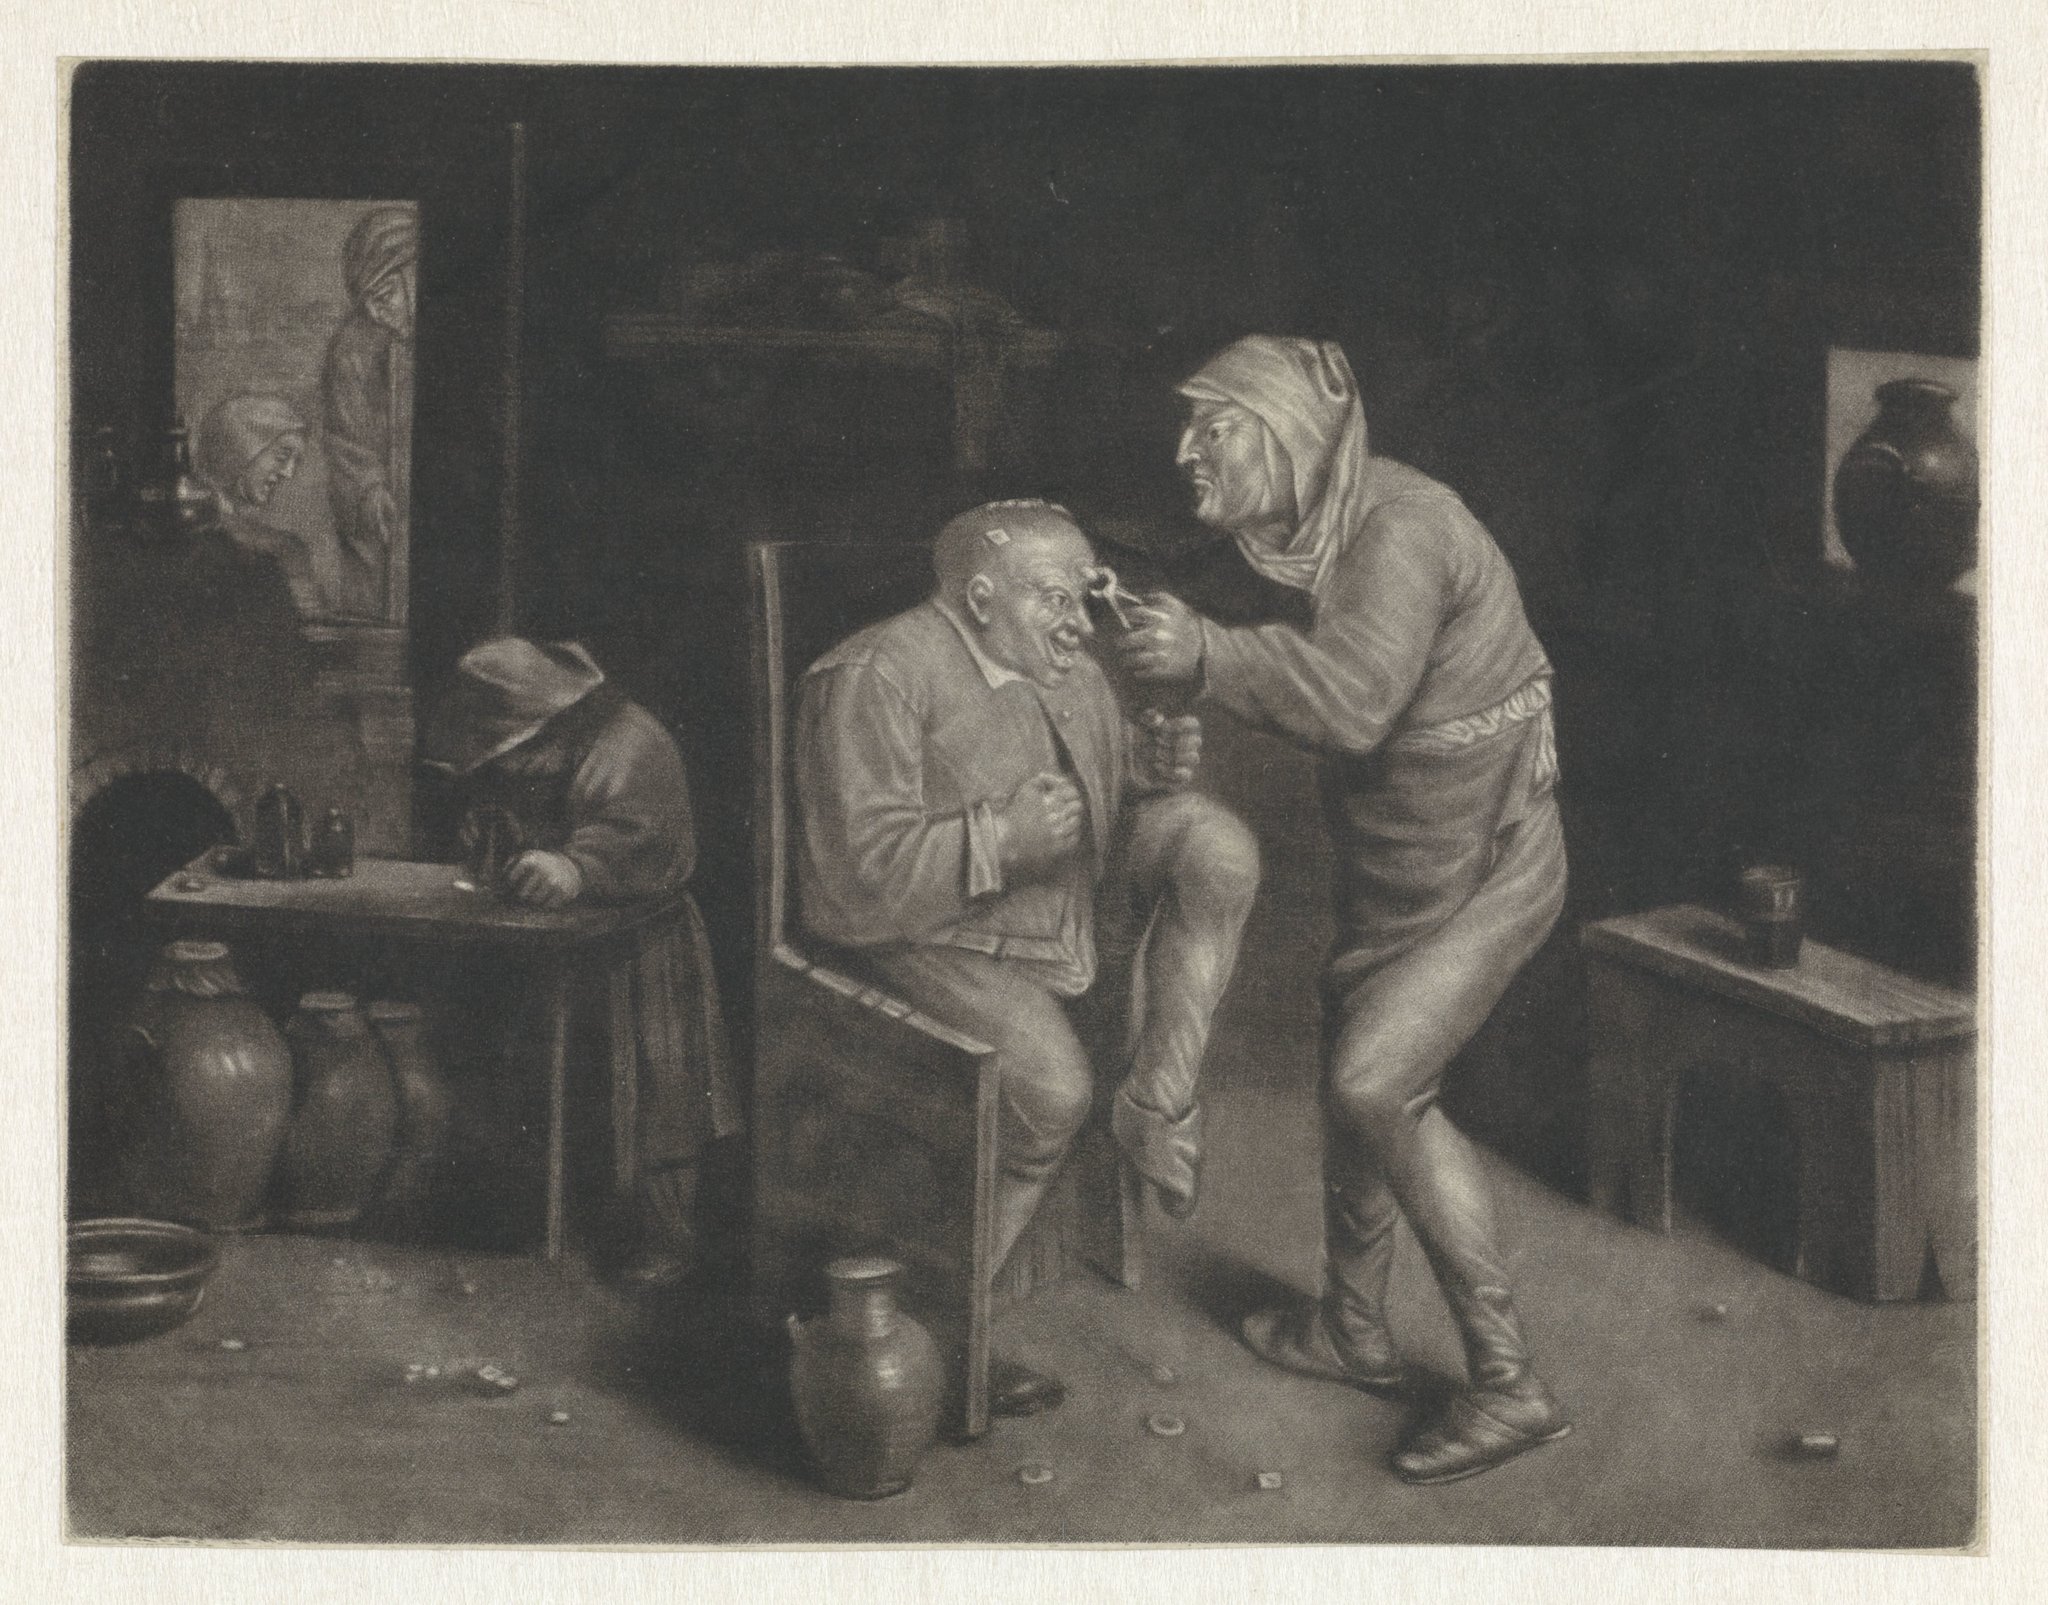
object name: print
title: Keisnijder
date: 1659-1740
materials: paper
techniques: mezzotint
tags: stone-operation, e.g.: by the witch of malleghem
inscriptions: collector's mark: Lugt 2228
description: Interieur waarin een kwakzalver een kei verwijdert uit het voorhoofd van een man. Deze balt zijn vuisten en schreeuwt het uit. Aan de tafel bereidt een jongen een geneesmiddel en op de grond liggen keien.